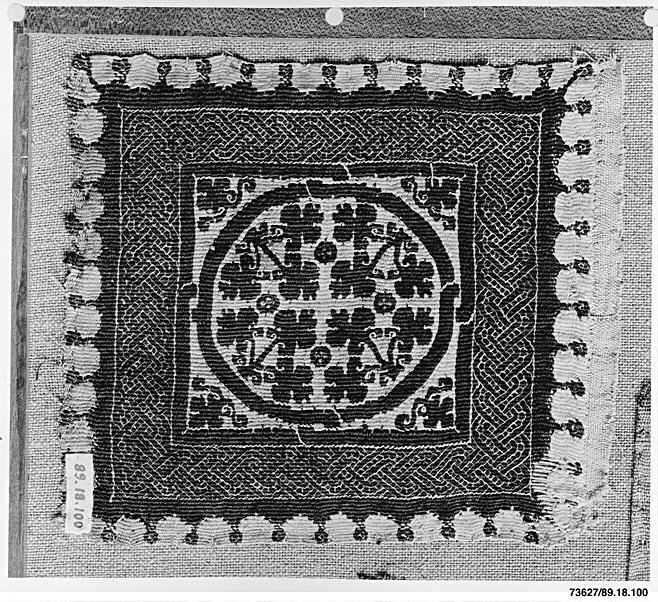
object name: textile fragment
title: Ornamental Tapestry Panel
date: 401-600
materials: linen, wool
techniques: weave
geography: egypt